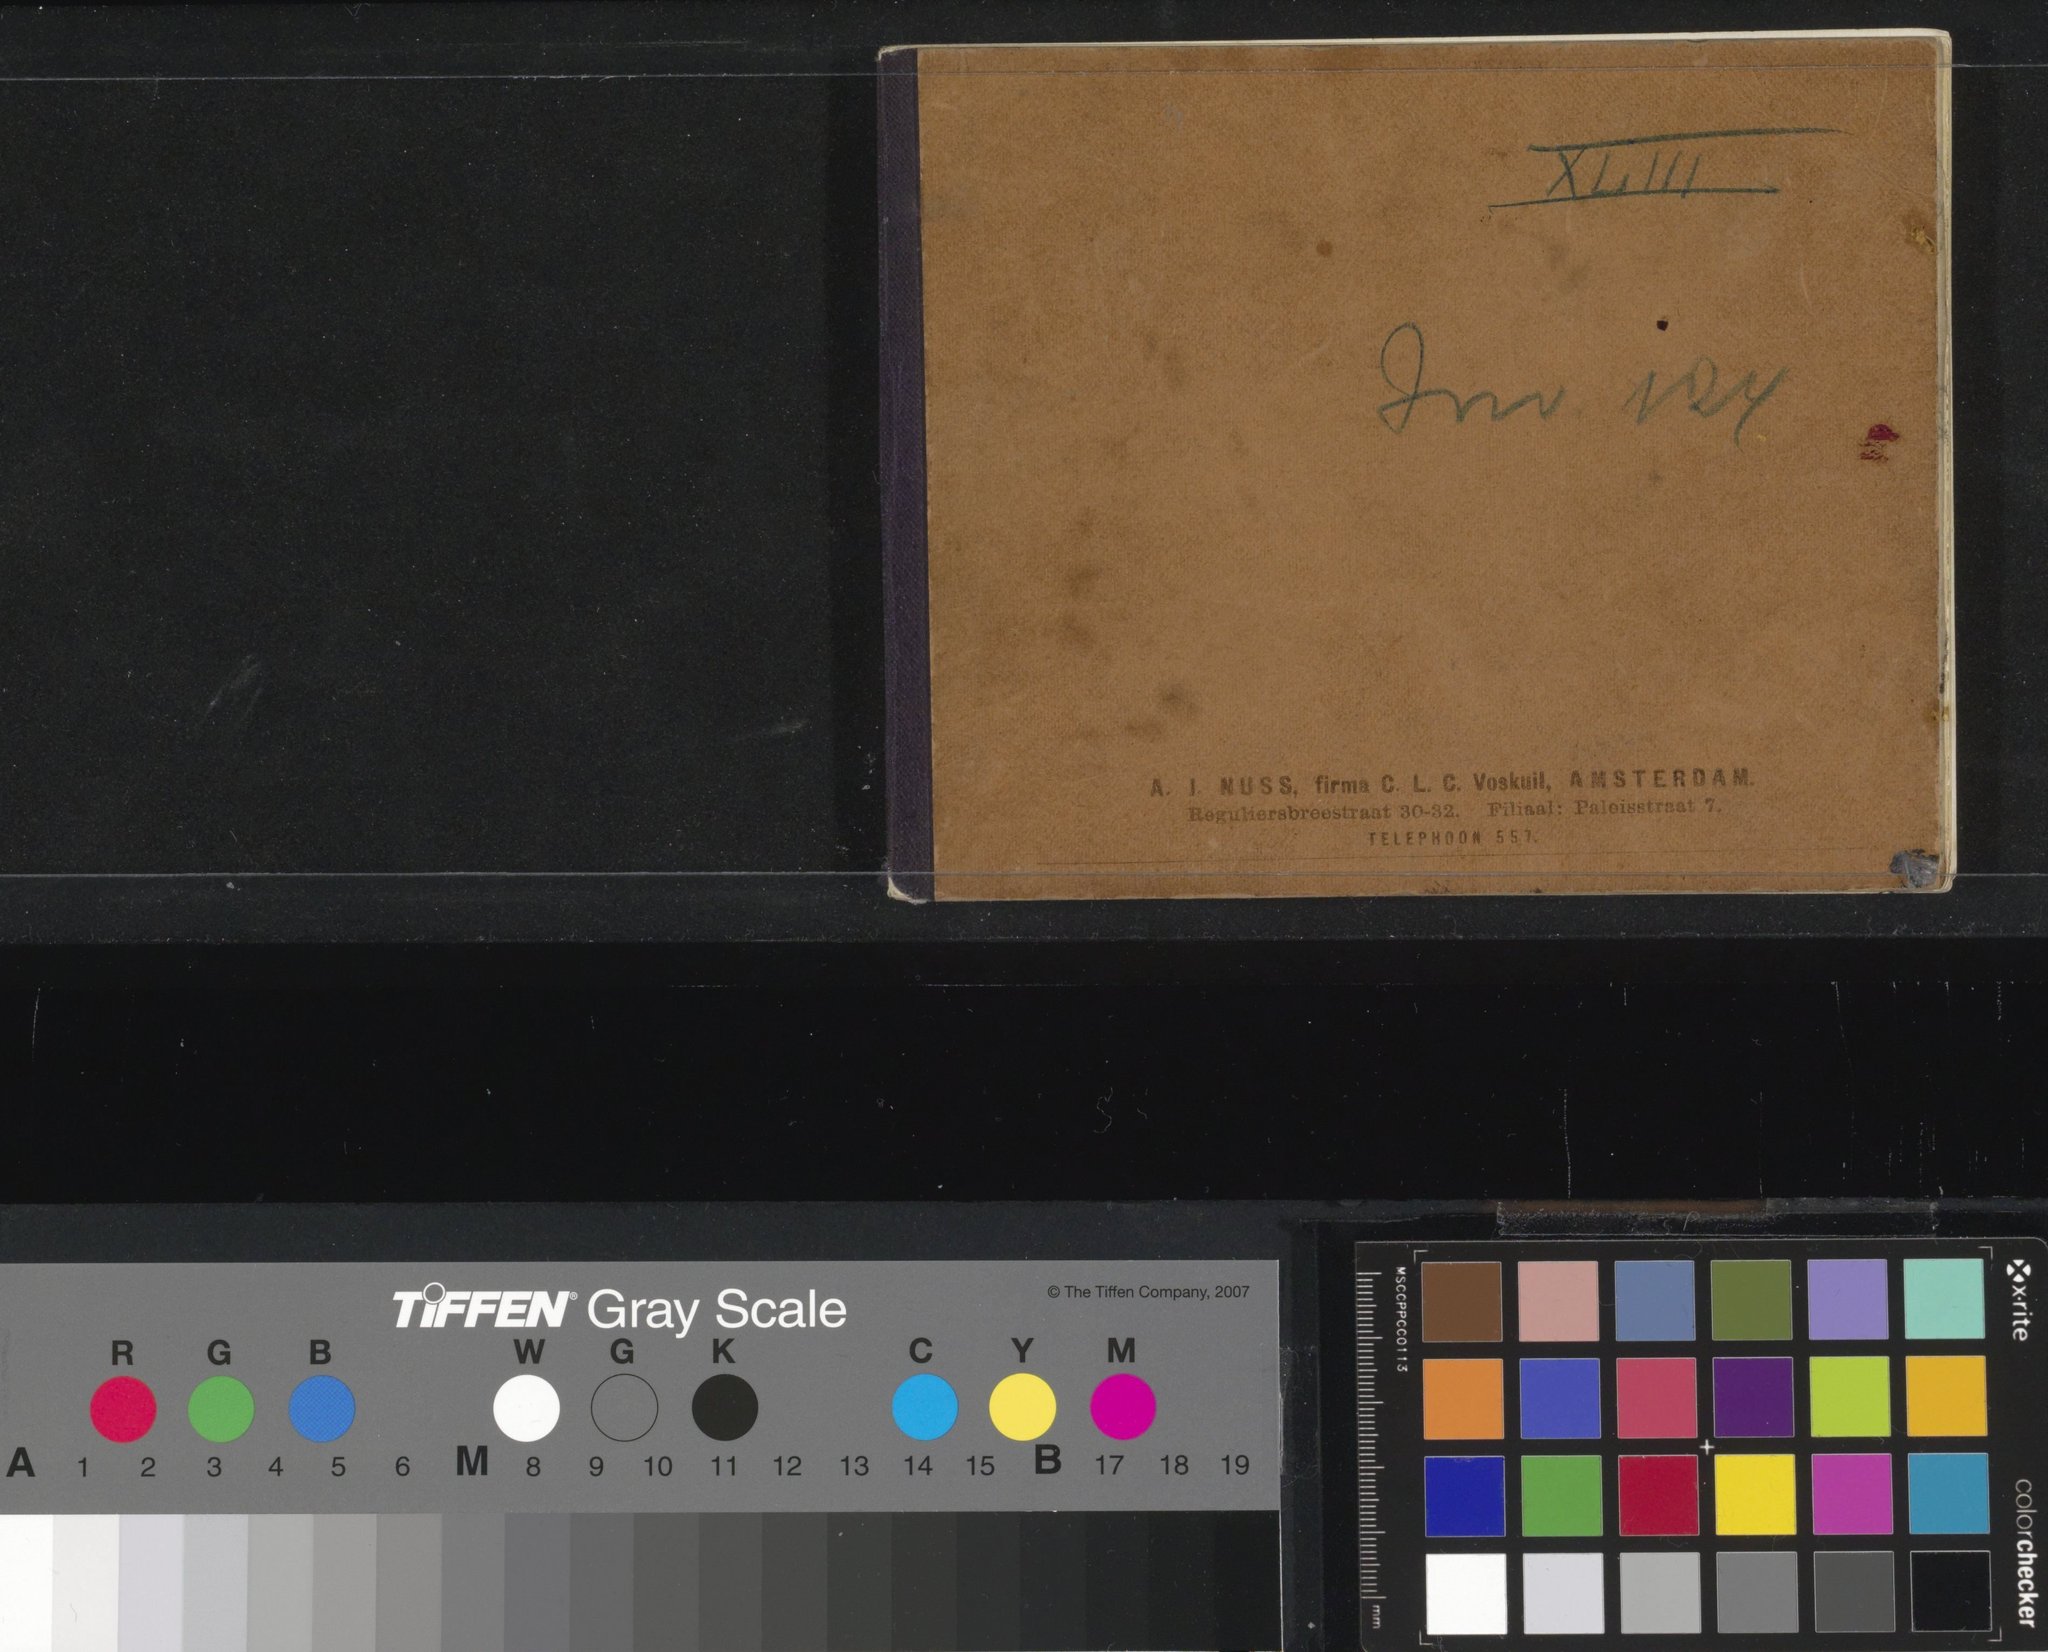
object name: sketchbook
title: Schetsboek XLIII met 61 pagina's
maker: isaac israels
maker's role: draughtsman, painter, print maker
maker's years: 1865-1934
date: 1875-1934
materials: cardboard, chalk, ink, linen, paper, pencil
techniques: pen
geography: the hague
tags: dressing-room ~ stage, head (human) - aa - female human figure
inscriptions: retailer's mark: ‘A.I. Nuss, firma C.L.C. Voskuil, Amsterdam. / Reguliersbreestraat 30-32. Filiaal: Paleisstraat 7. / Telephoon 557.’, collector's mark: Lugt 2228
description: Pagina's 1 (voorste schutblad), 7, 8, 20, 43, 44, 49, 50 en 59 zijn blanco en daarom niet beschreven